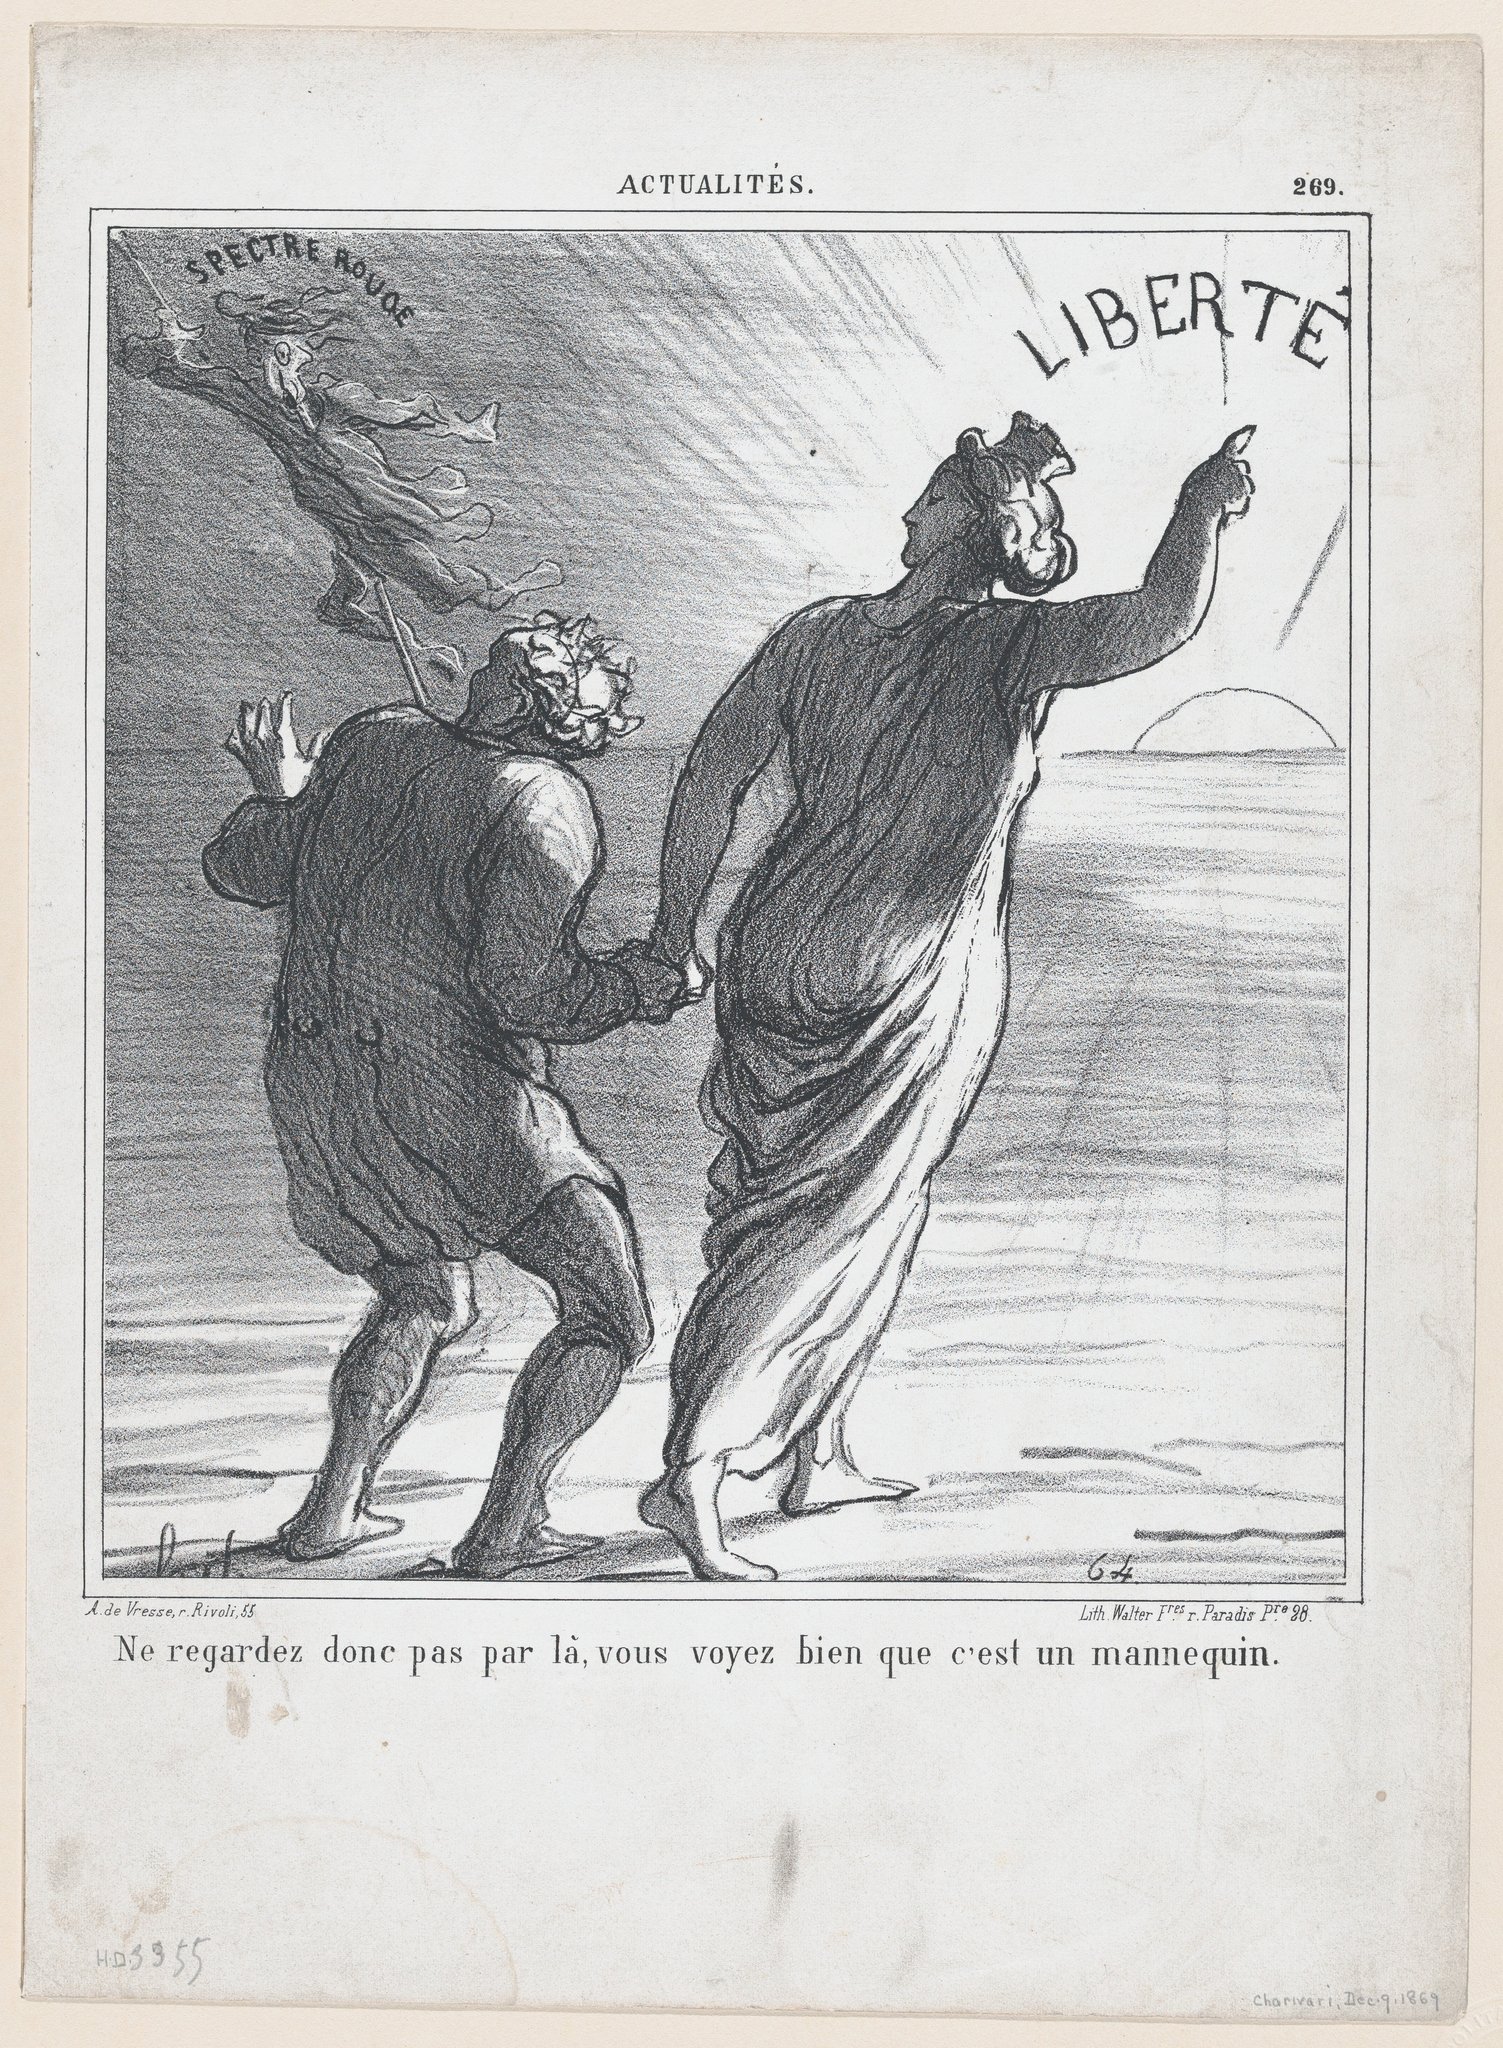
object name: print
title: Don't look in that direction, don't you see that it's just a scare-crow, from 'News of the day,' published in "Le Charivari"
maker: honoré daumier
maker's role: artist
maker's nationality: french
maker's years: 1808-1879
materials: paper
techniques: lithograph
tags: men,women,sun